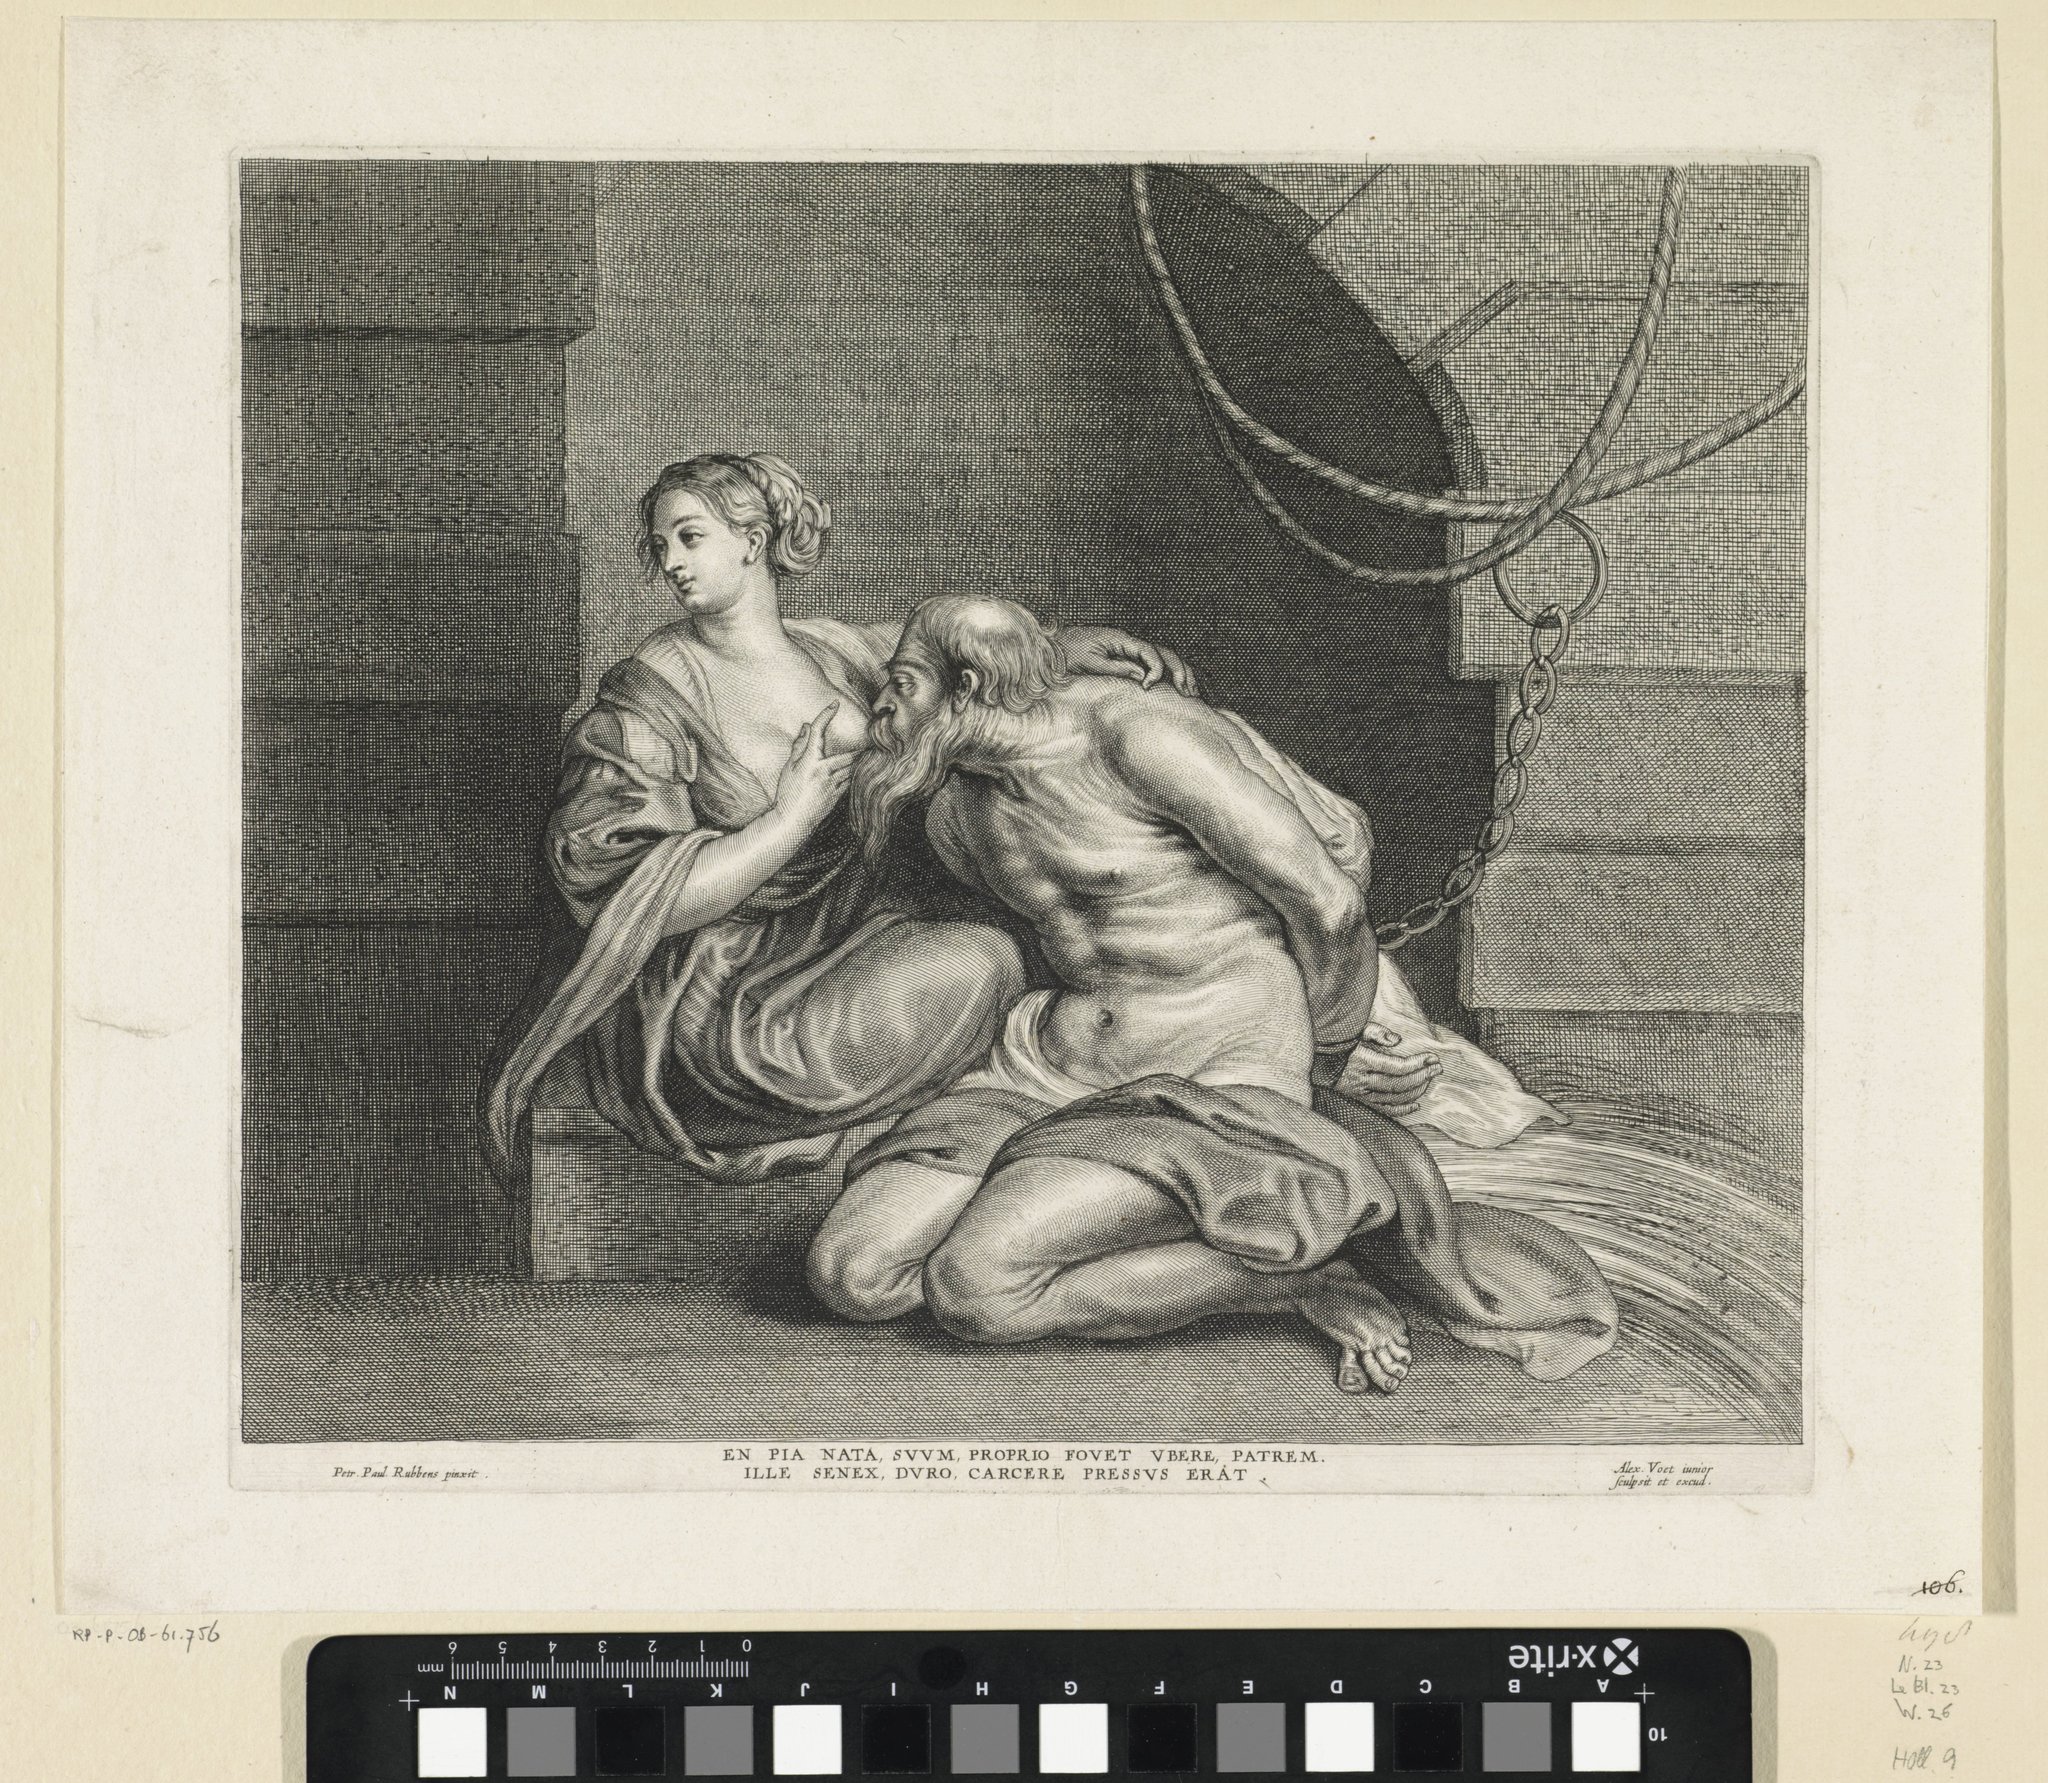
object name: print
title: Cimon en Pero (Caritas Romana)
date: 1662-1695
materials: paper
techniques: engraving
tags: pero suckling cimon ('caritas romana')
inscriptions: collector's mark: Lugt 240, collector's mark: Lugt 240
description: Kopie in spiegelbeeld naar het schilderij door Peter Paul Rubens in het Rijksmuseum, objectnummer SK-A-345..